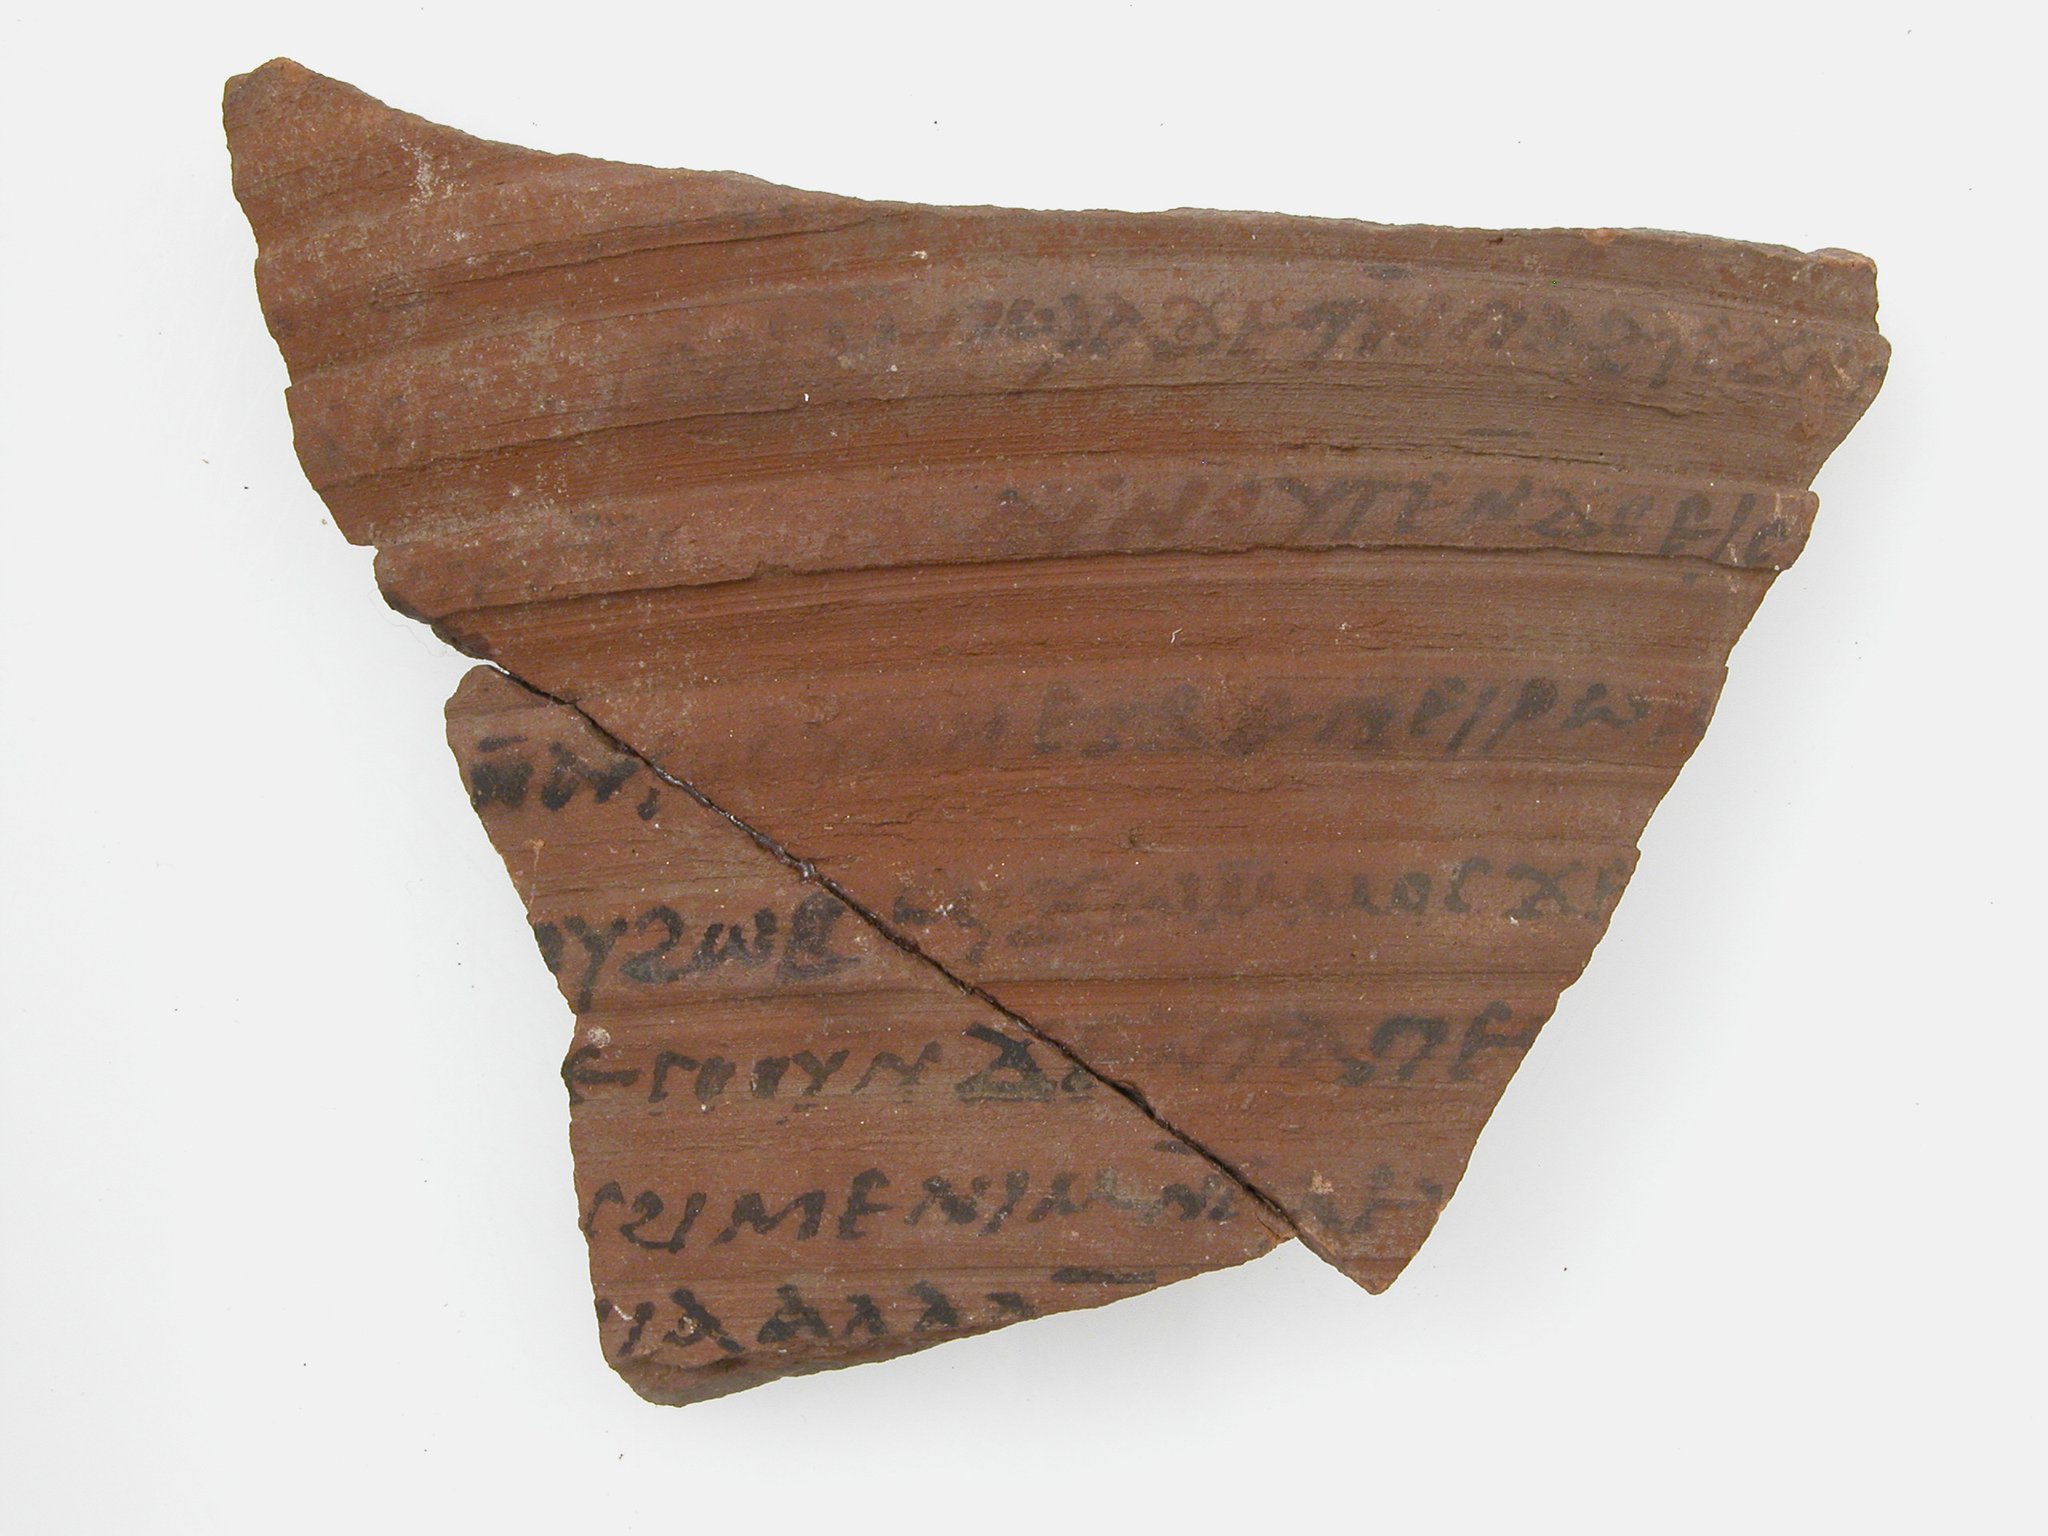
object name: ostrakon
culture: coptic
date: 601-700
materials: ink, pottery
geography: egypt